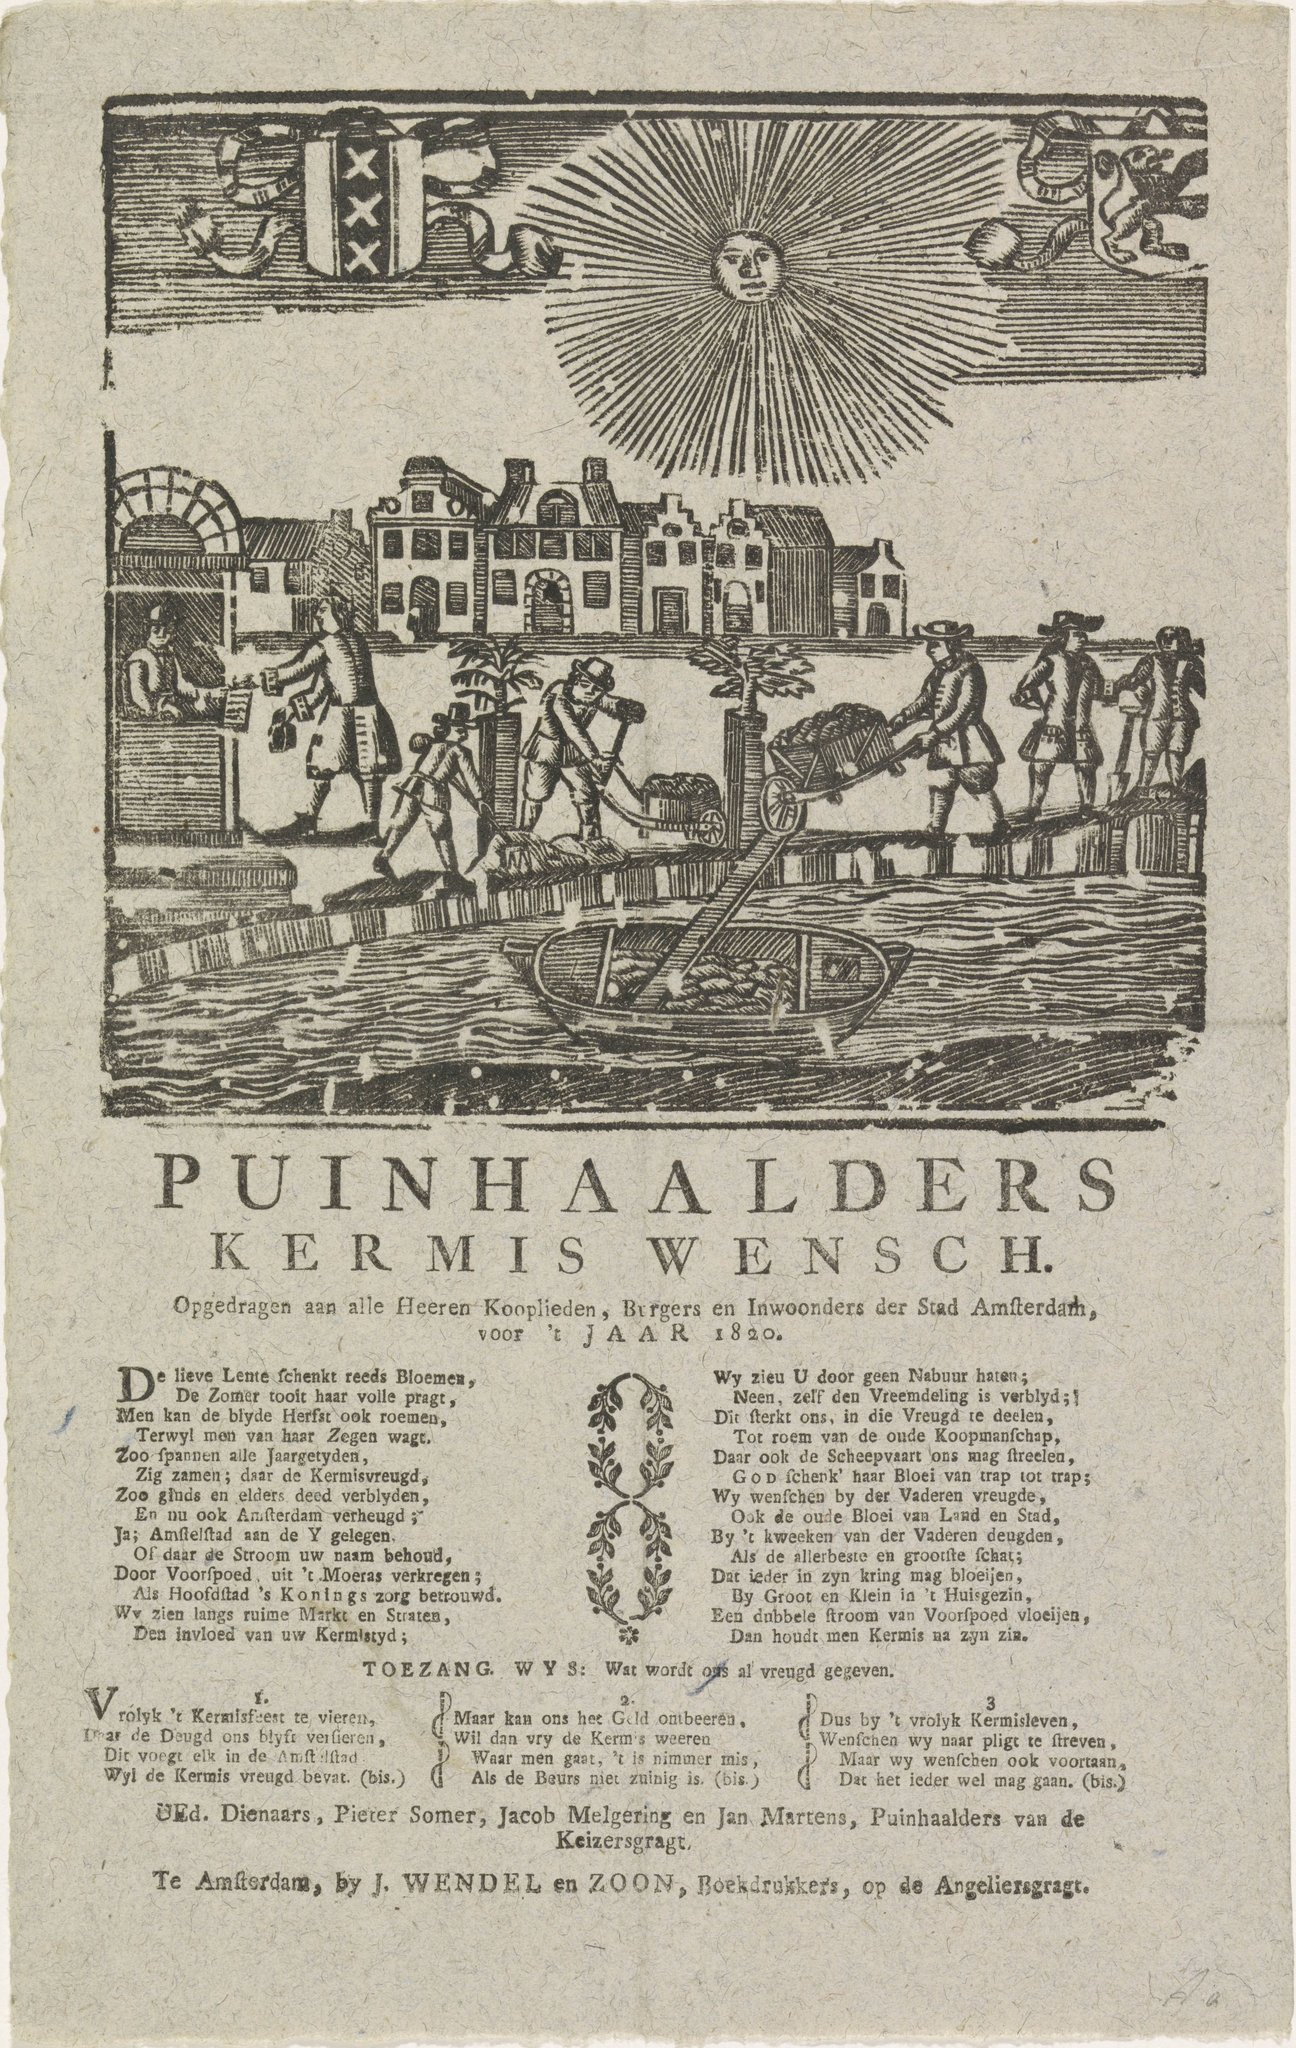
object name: print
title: Kermisprent van de Amsterdamse puinhaalders, 1820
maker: Anonymous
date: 1815-1820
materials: paper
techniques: letterpress printing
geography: amsterdam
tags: canals, waters (in city), garbage collection, amsterdam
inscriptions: collector's mark: Lugt 2228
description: Kermisprent van de Amsterdamse puinhaalders voor het jaar 1820. Puinophalers brengen het puin met kruiwagens naar een schuit in de gracht. Op de achtergrond een rijtje huizen aan een gracht, in de hemel de stralende zon tussen de wapens van Amsterdam en Holland. Met een vers in twee kolommen en een lied in drie coupletten. Namens: Pieter Somer, Jacob Melgering en Jan Martens, puinhaalders aan de Keizersgracht.